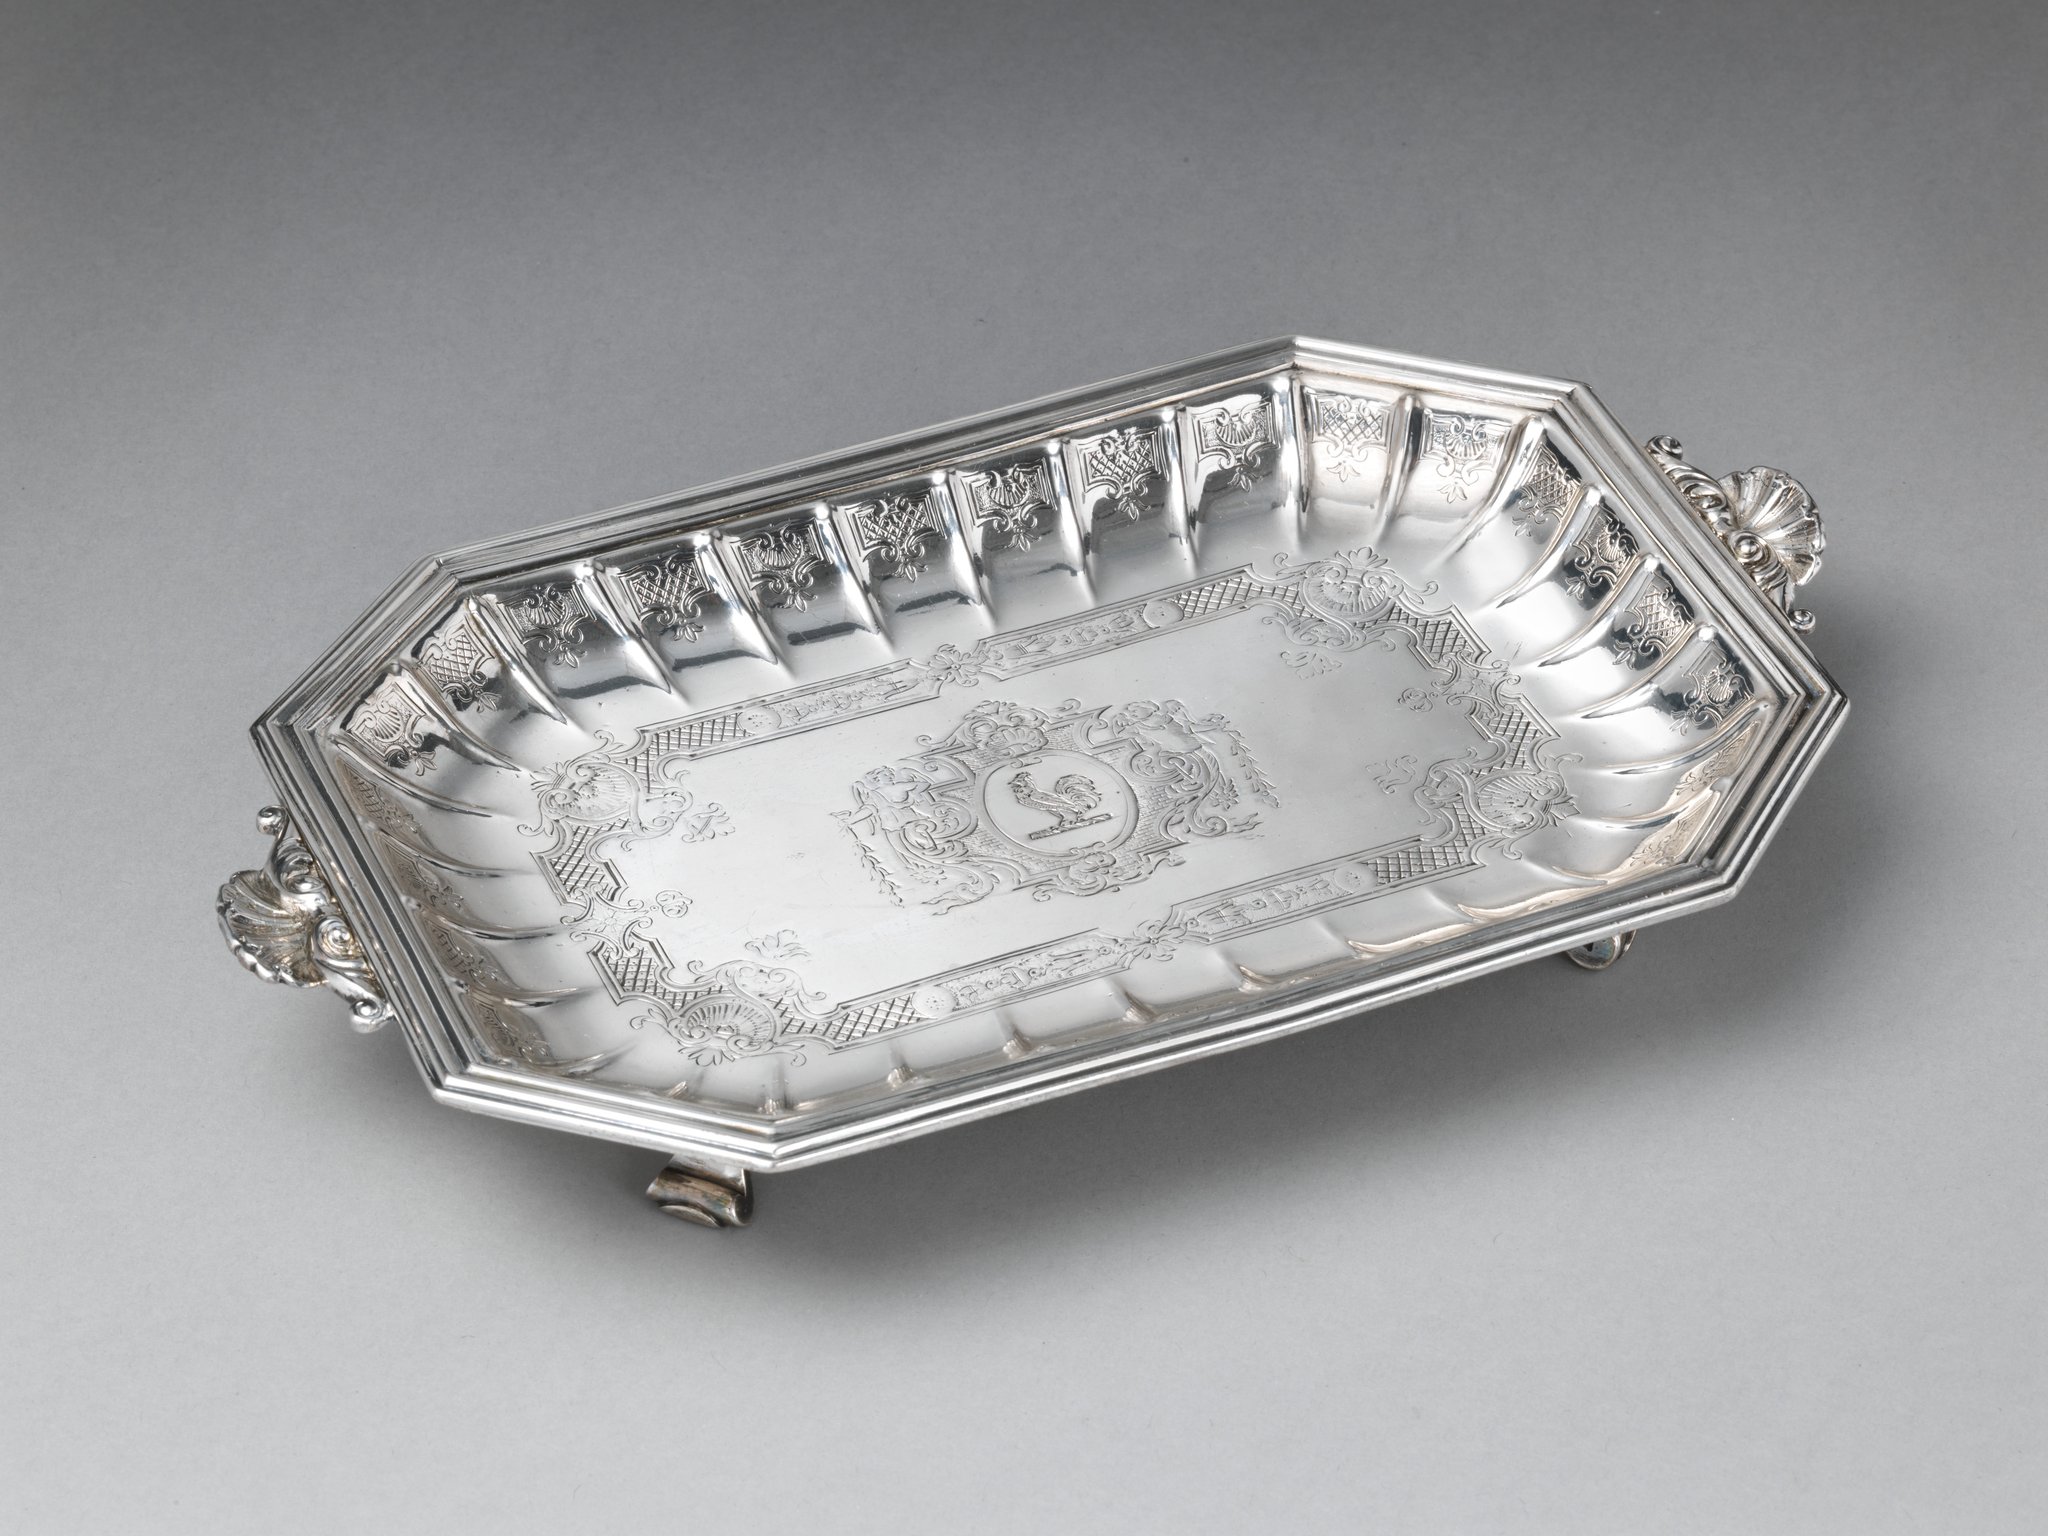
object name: spoon tray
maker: paul de lamerie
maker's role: maker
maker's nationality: british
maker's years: 1688-1751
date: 1732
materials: silver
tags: roosters